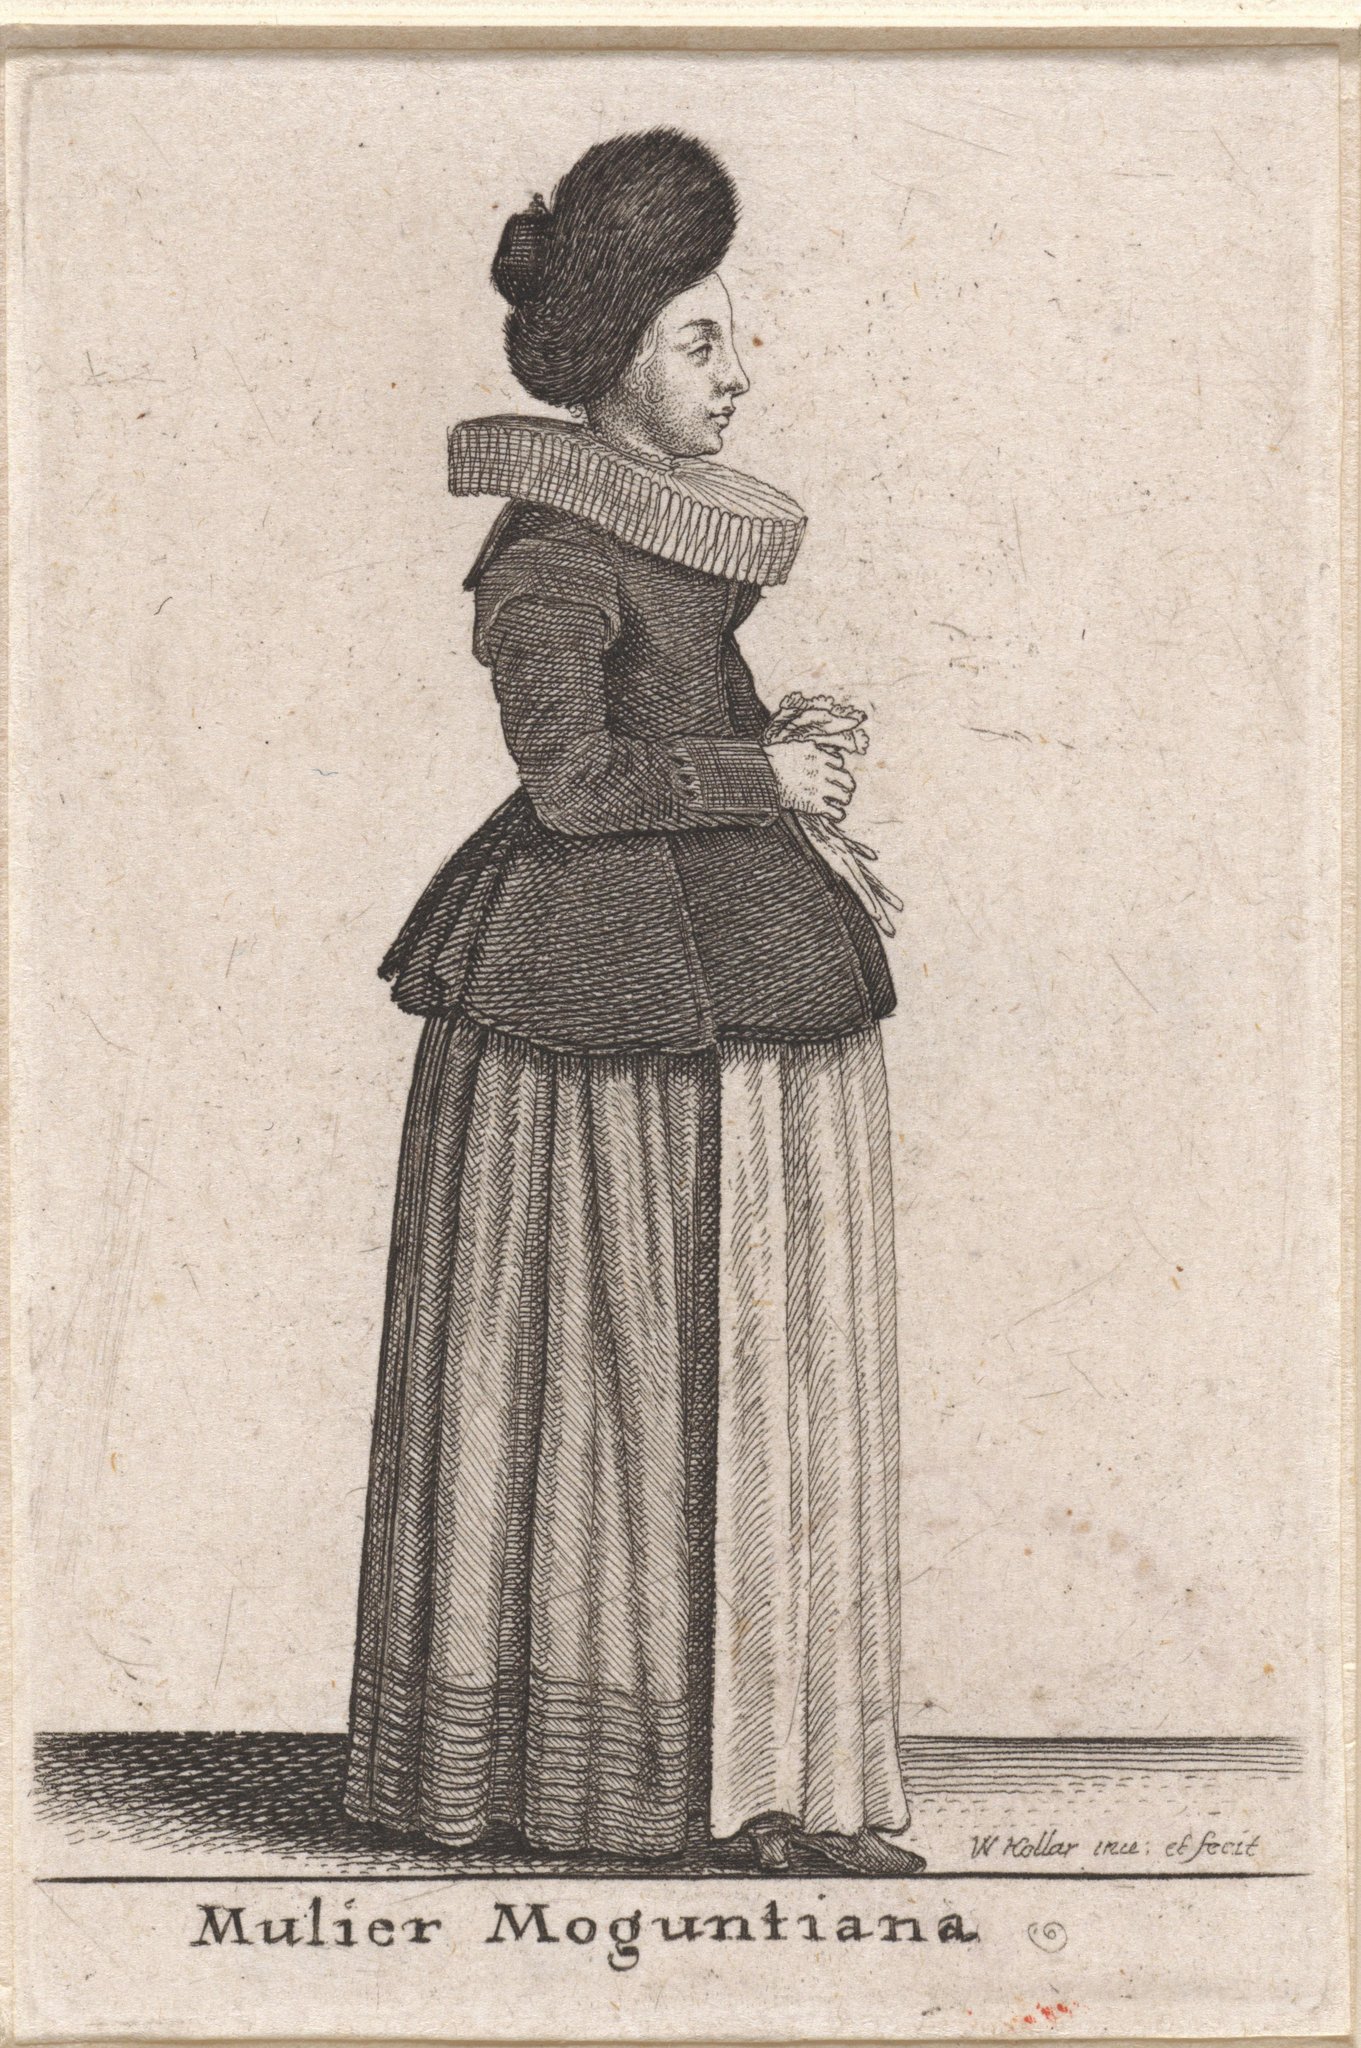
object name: costume print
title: Mulier Moguntiana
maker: wenceslaus hollar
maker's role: draughtsman, print maker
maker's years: 1607-1677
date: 1643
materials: paper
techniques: etching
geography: london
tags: europeans: germans (+ women), neck-gear ~ clothing (with name) (+ women's clothes), gloves, mittens, etc. (+ women's clothes), head-gear: cap (+ fur used for clothes)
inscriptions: collector's mark: Lugt 240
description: Vrouw uit Mainz, in profiel naar rechts, met schuin op het achterhoofd een kapje met een zeer brede bontrand die het gezicht omsluit. Brede, dikke plooikraag waarin rond de hals het boord van het hemd zichtbaar is. Nauwsluitend heuplang jak met platte kraag op de rug, bragoenen, lange mouwen en een schoot uit verschillende losse panden bestaand. Teruggeslagen manchetten afgezet met een gekartelde rand (kant?). Voetlange, ruime rok boven de zoom versierd met een aantal horizontale banden. Lang wit schort dat in de taille onder het jak begint. Schoenen met middelhoge hak. In de linkerhand handschoenen met kappen afgezet met een gerimpelde strook.